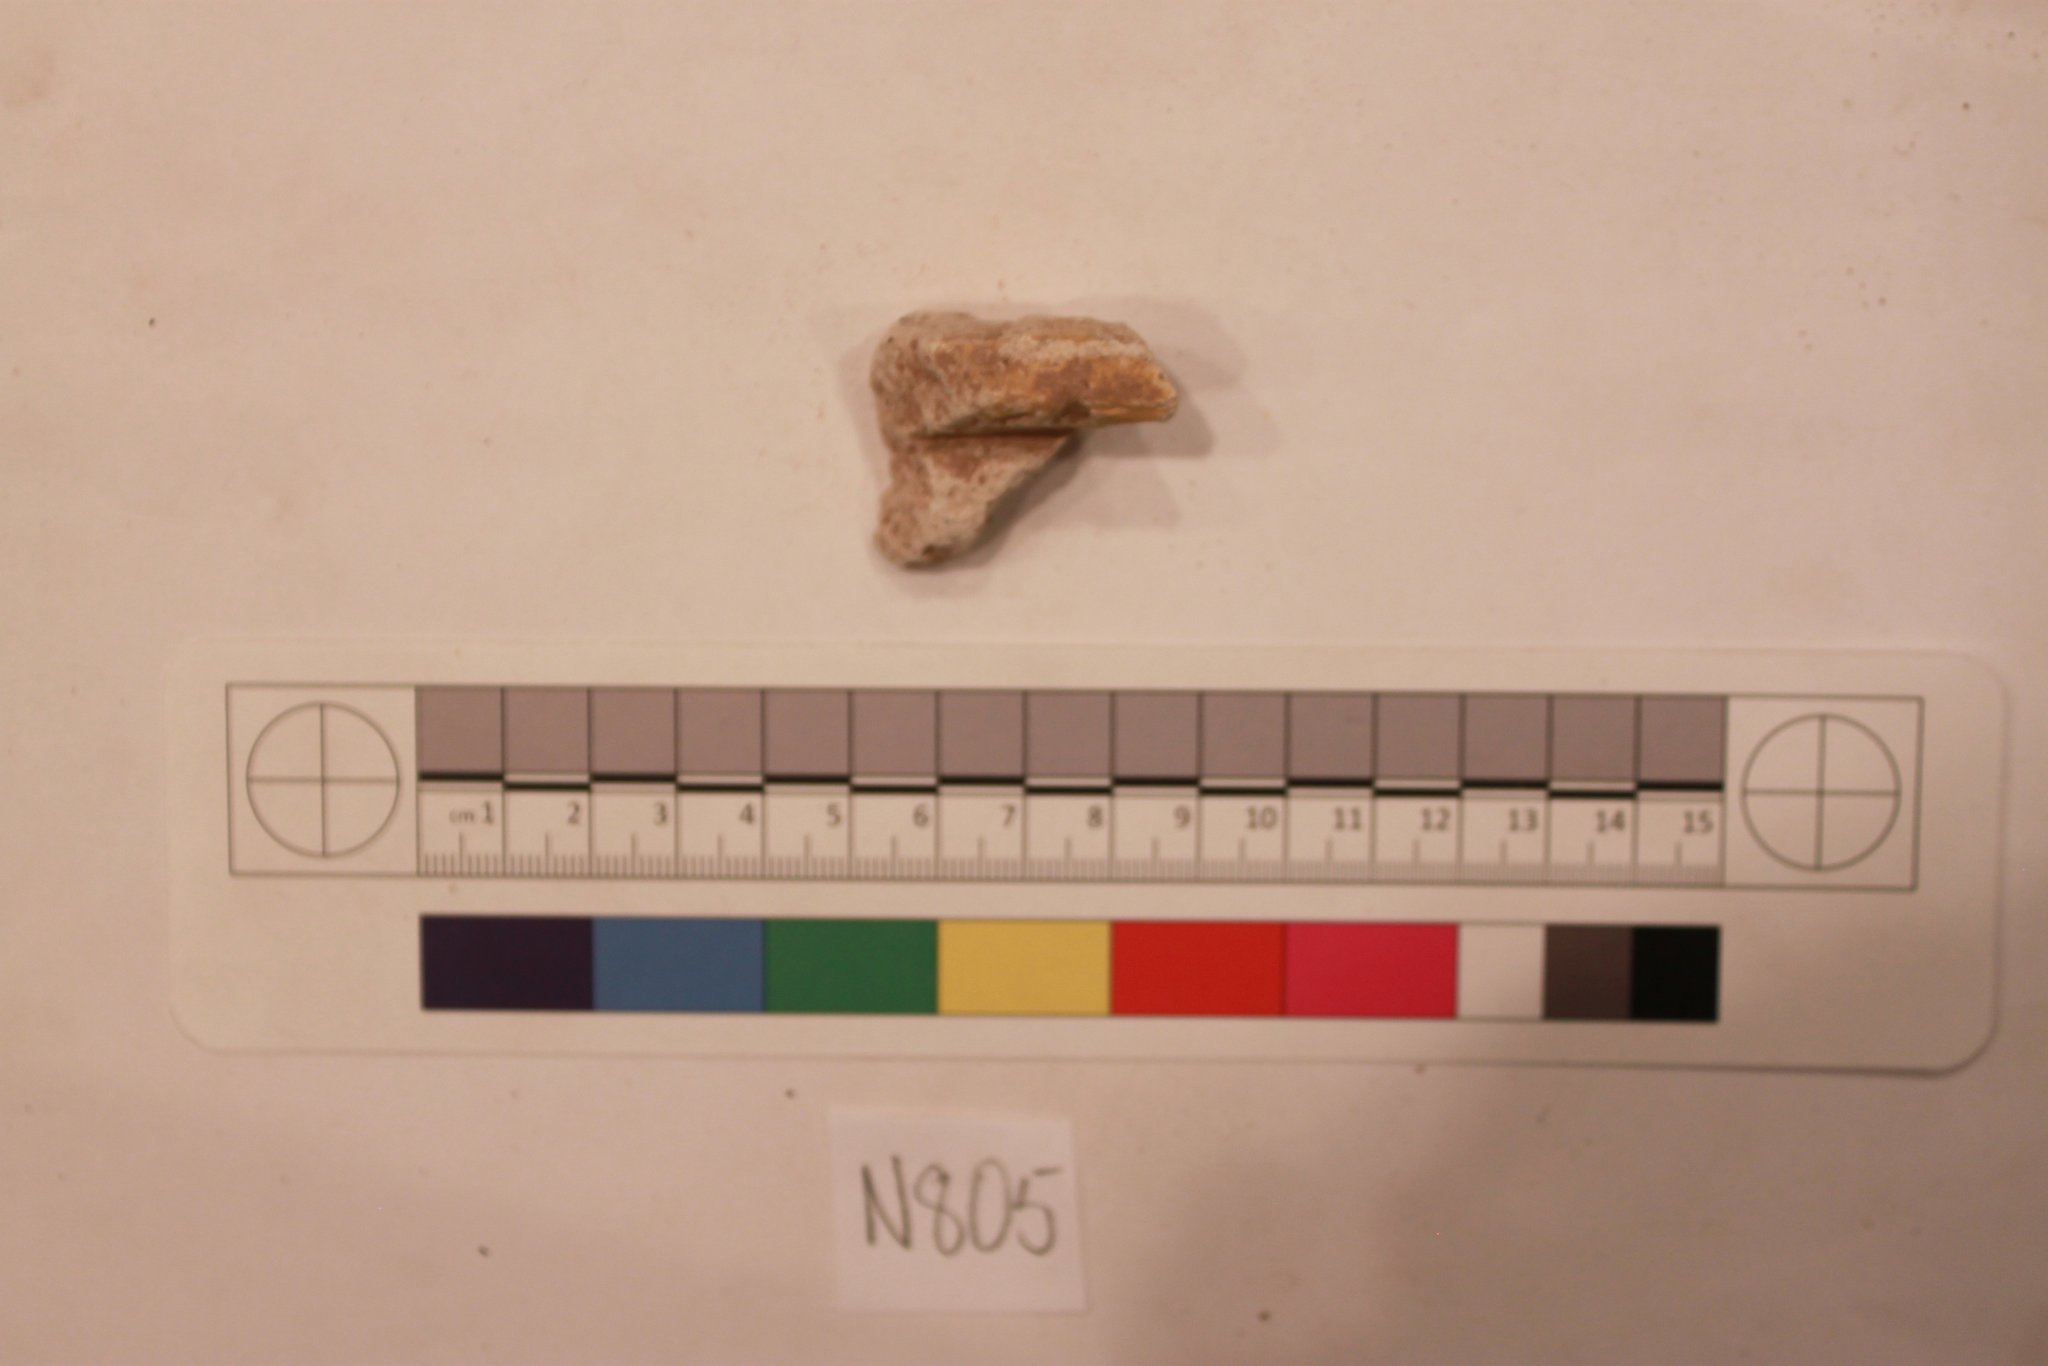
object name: fragment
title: Stucco Fragment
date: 701-1200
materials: plaster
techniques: carving, painting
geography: iran